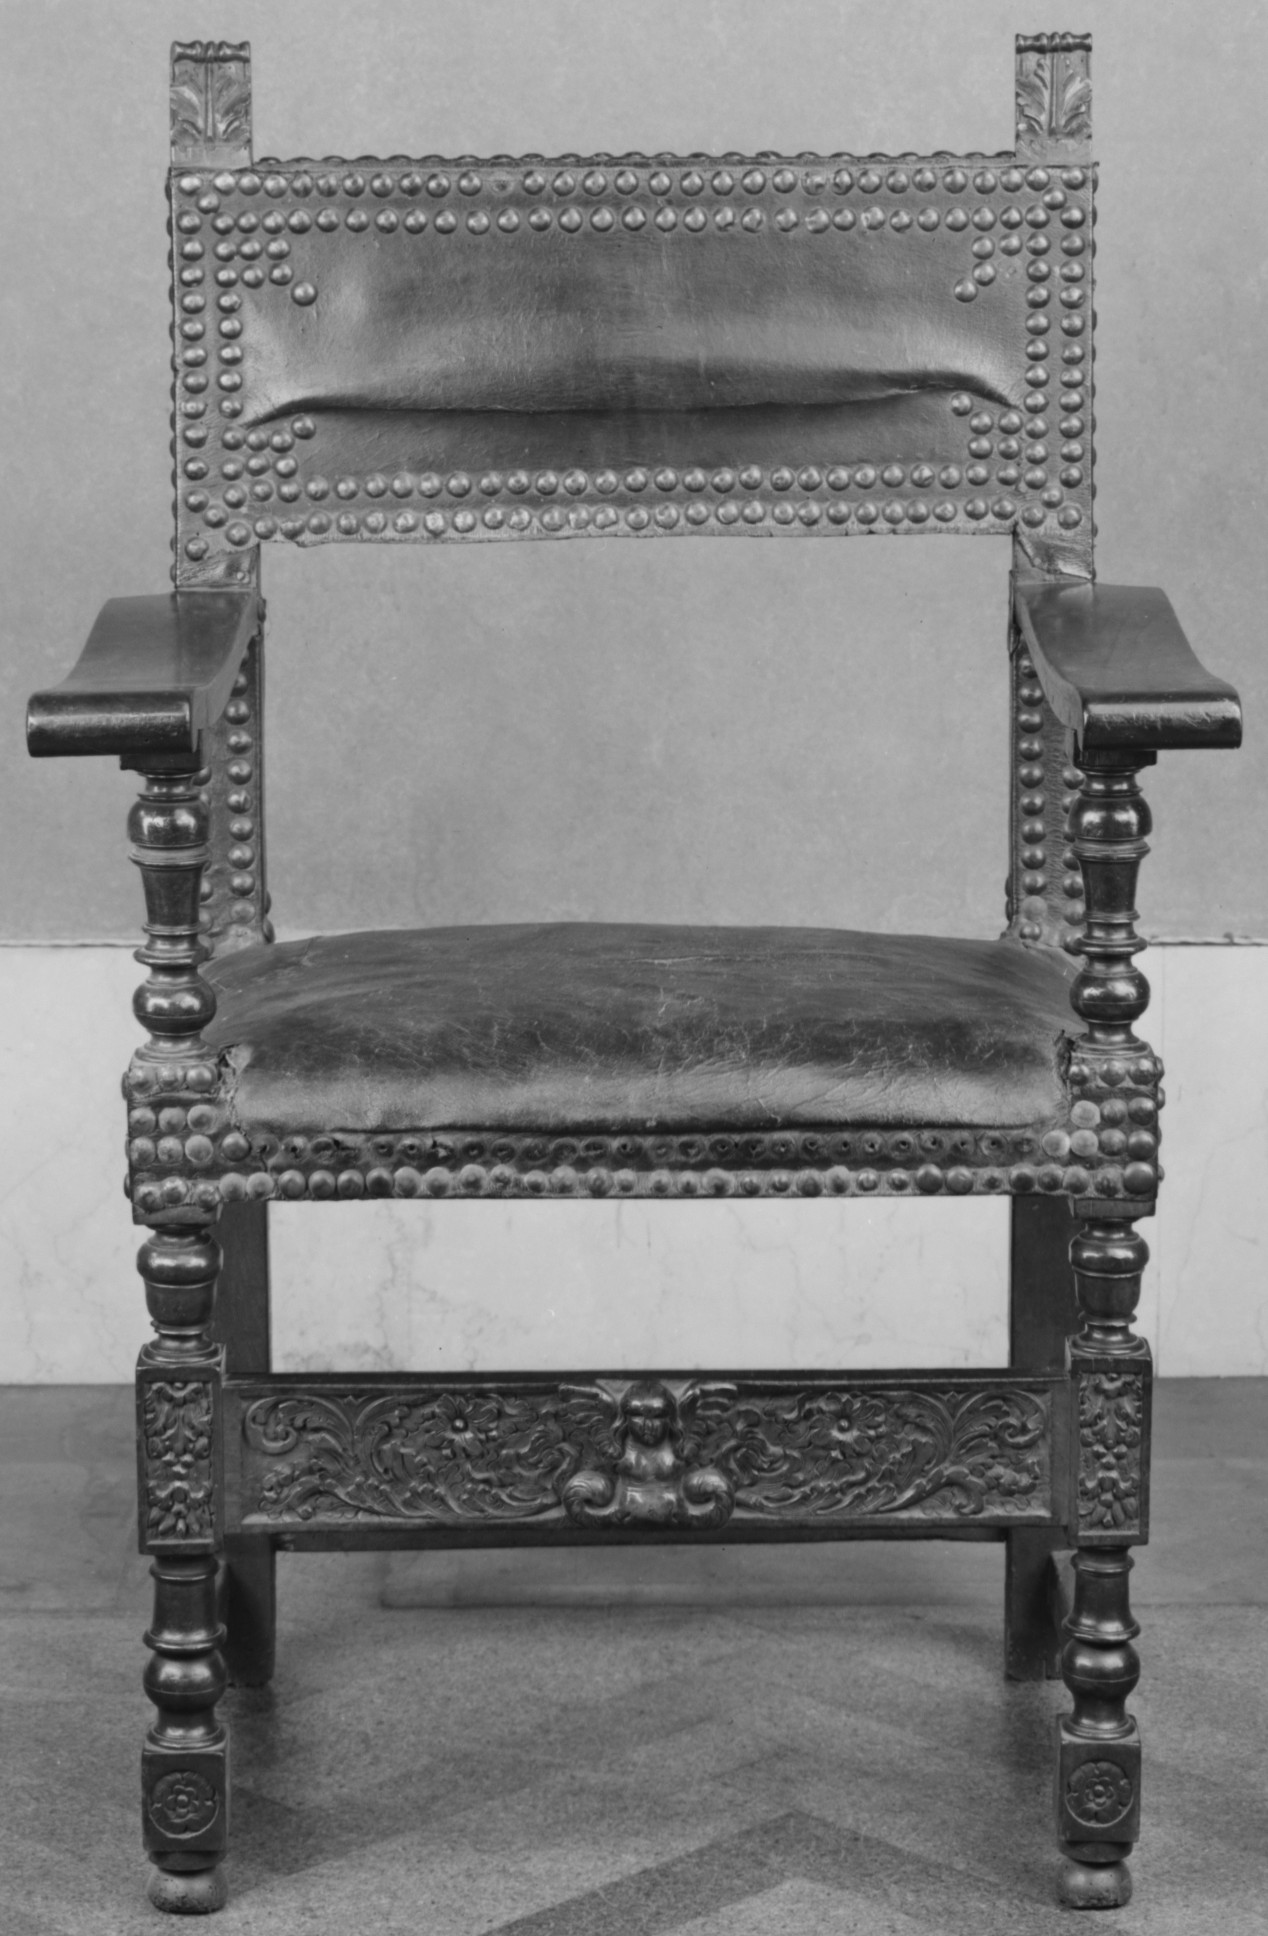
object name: armchair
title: Pair of armchairs (part of a set)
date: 1567-1600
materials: leather, wood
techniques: carving